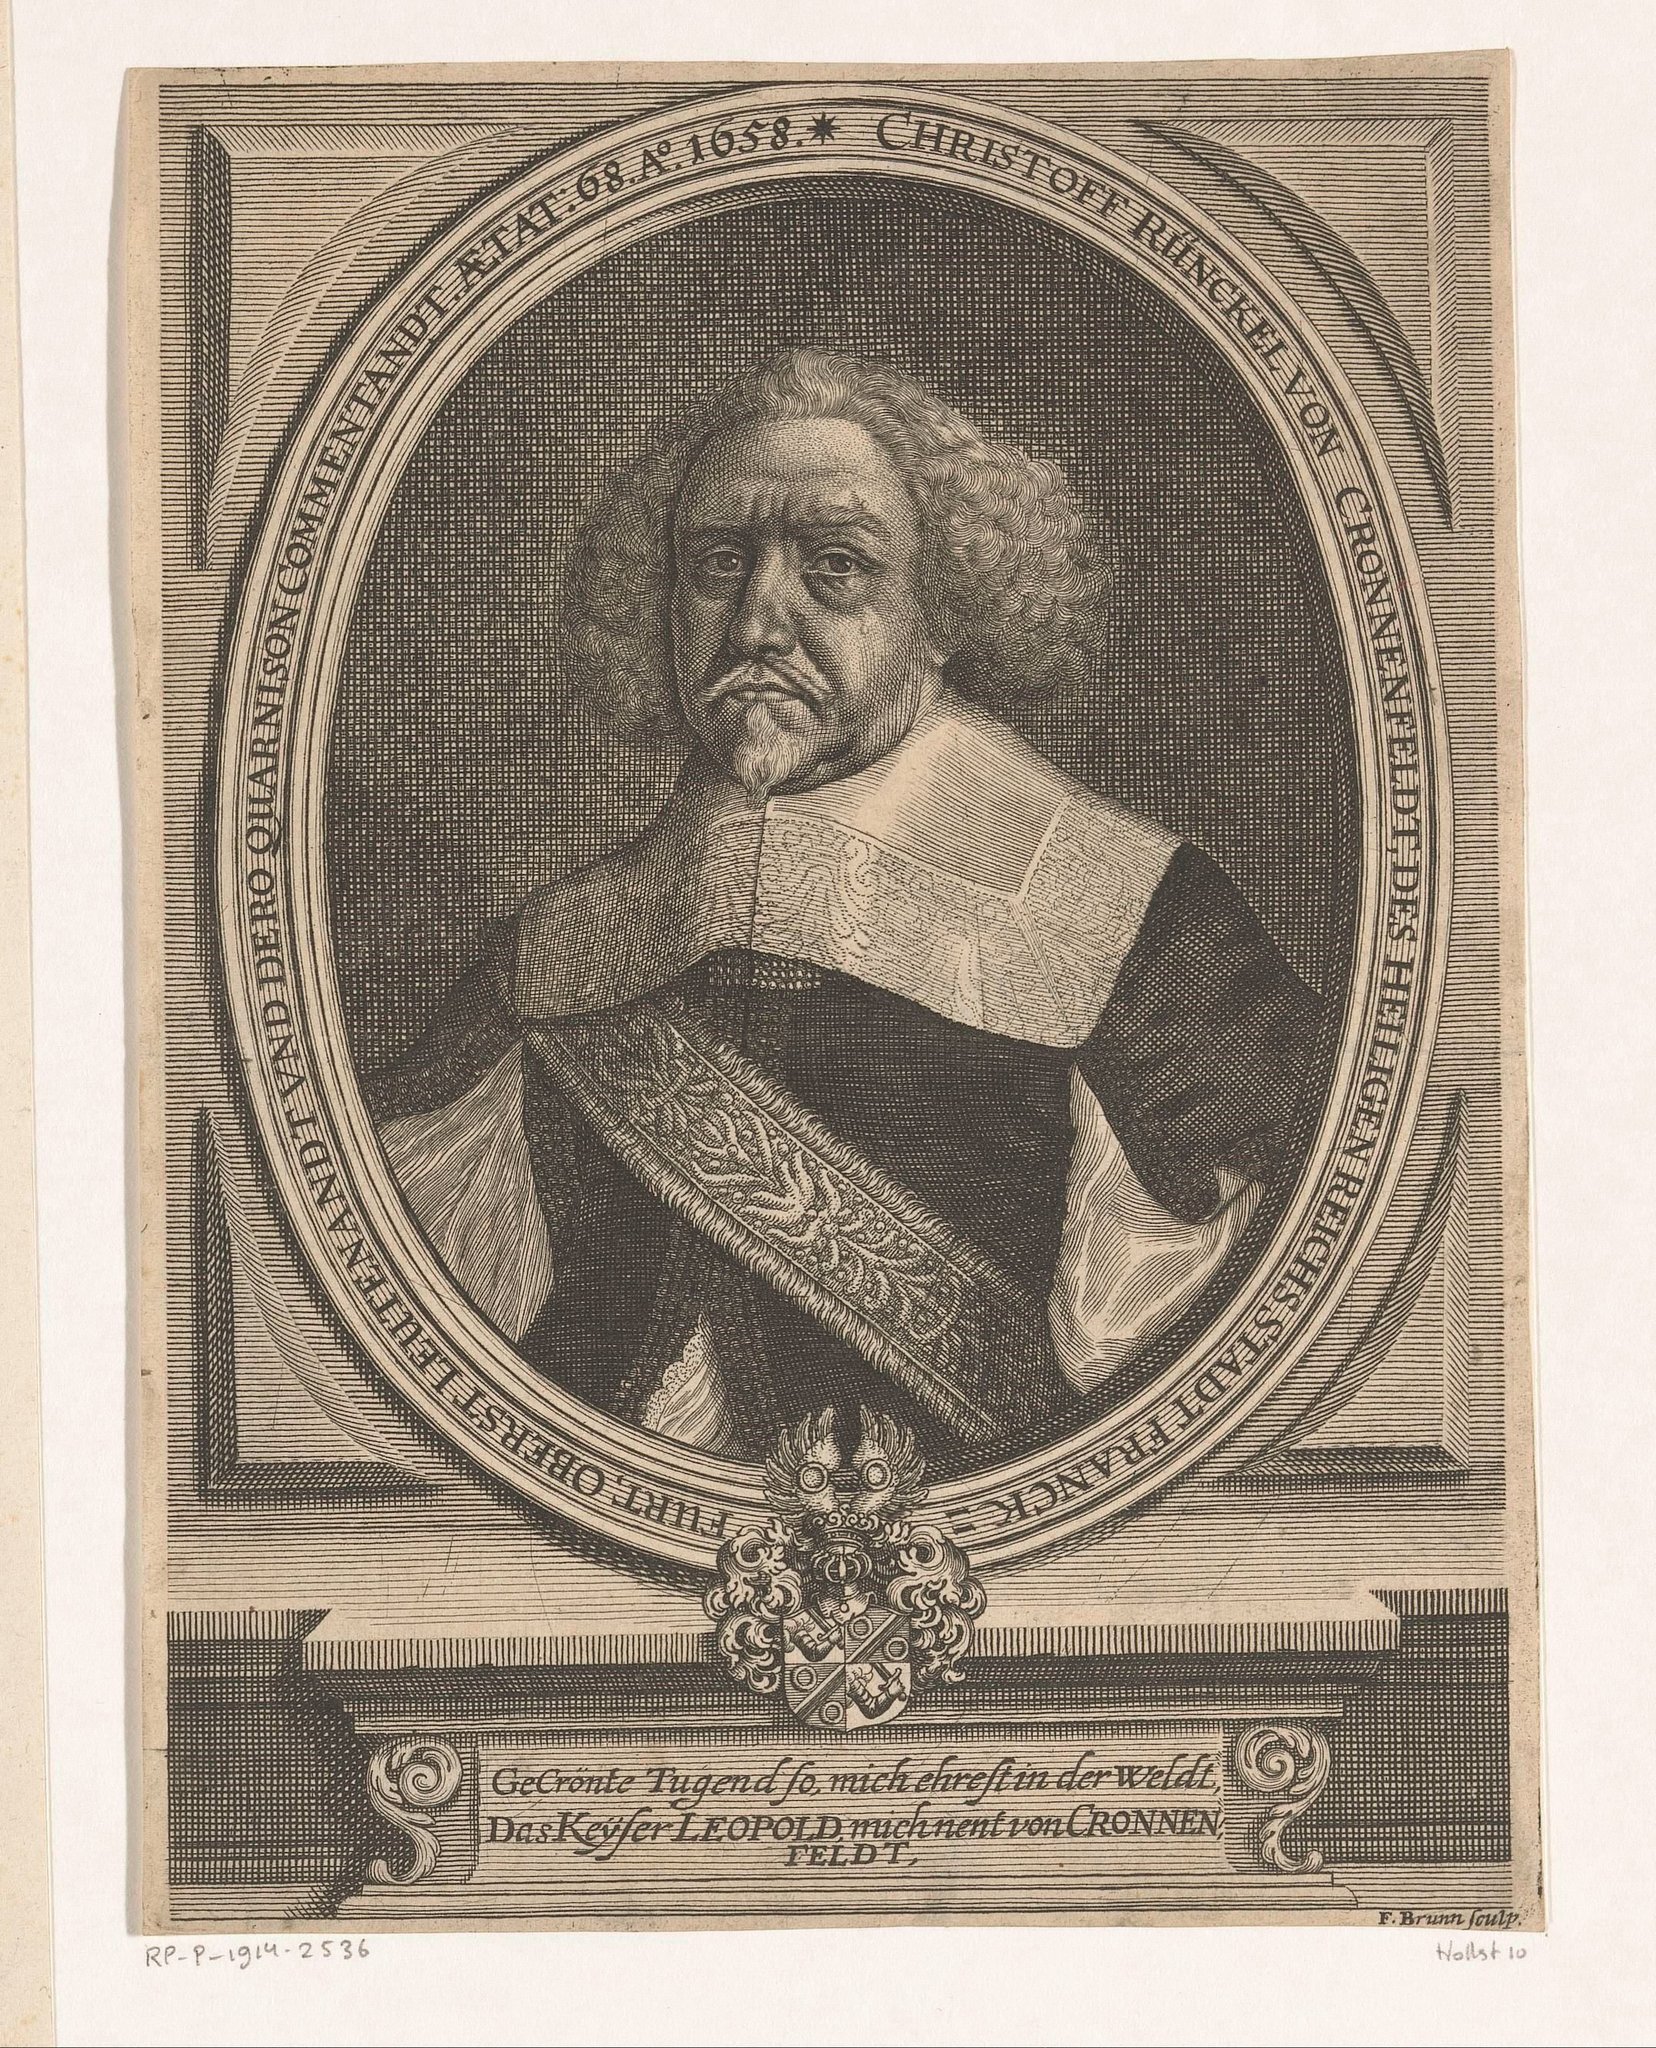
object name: print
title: Portret van Christoph Rünckel von Cronnenfeldt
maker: franz brun (ii)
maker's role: print maker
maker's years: -1658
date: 1658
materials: paper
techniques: engraving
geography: cologne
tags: historical persons, armorial bearing, heraldry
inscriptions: collector's mark: Lugt 2228